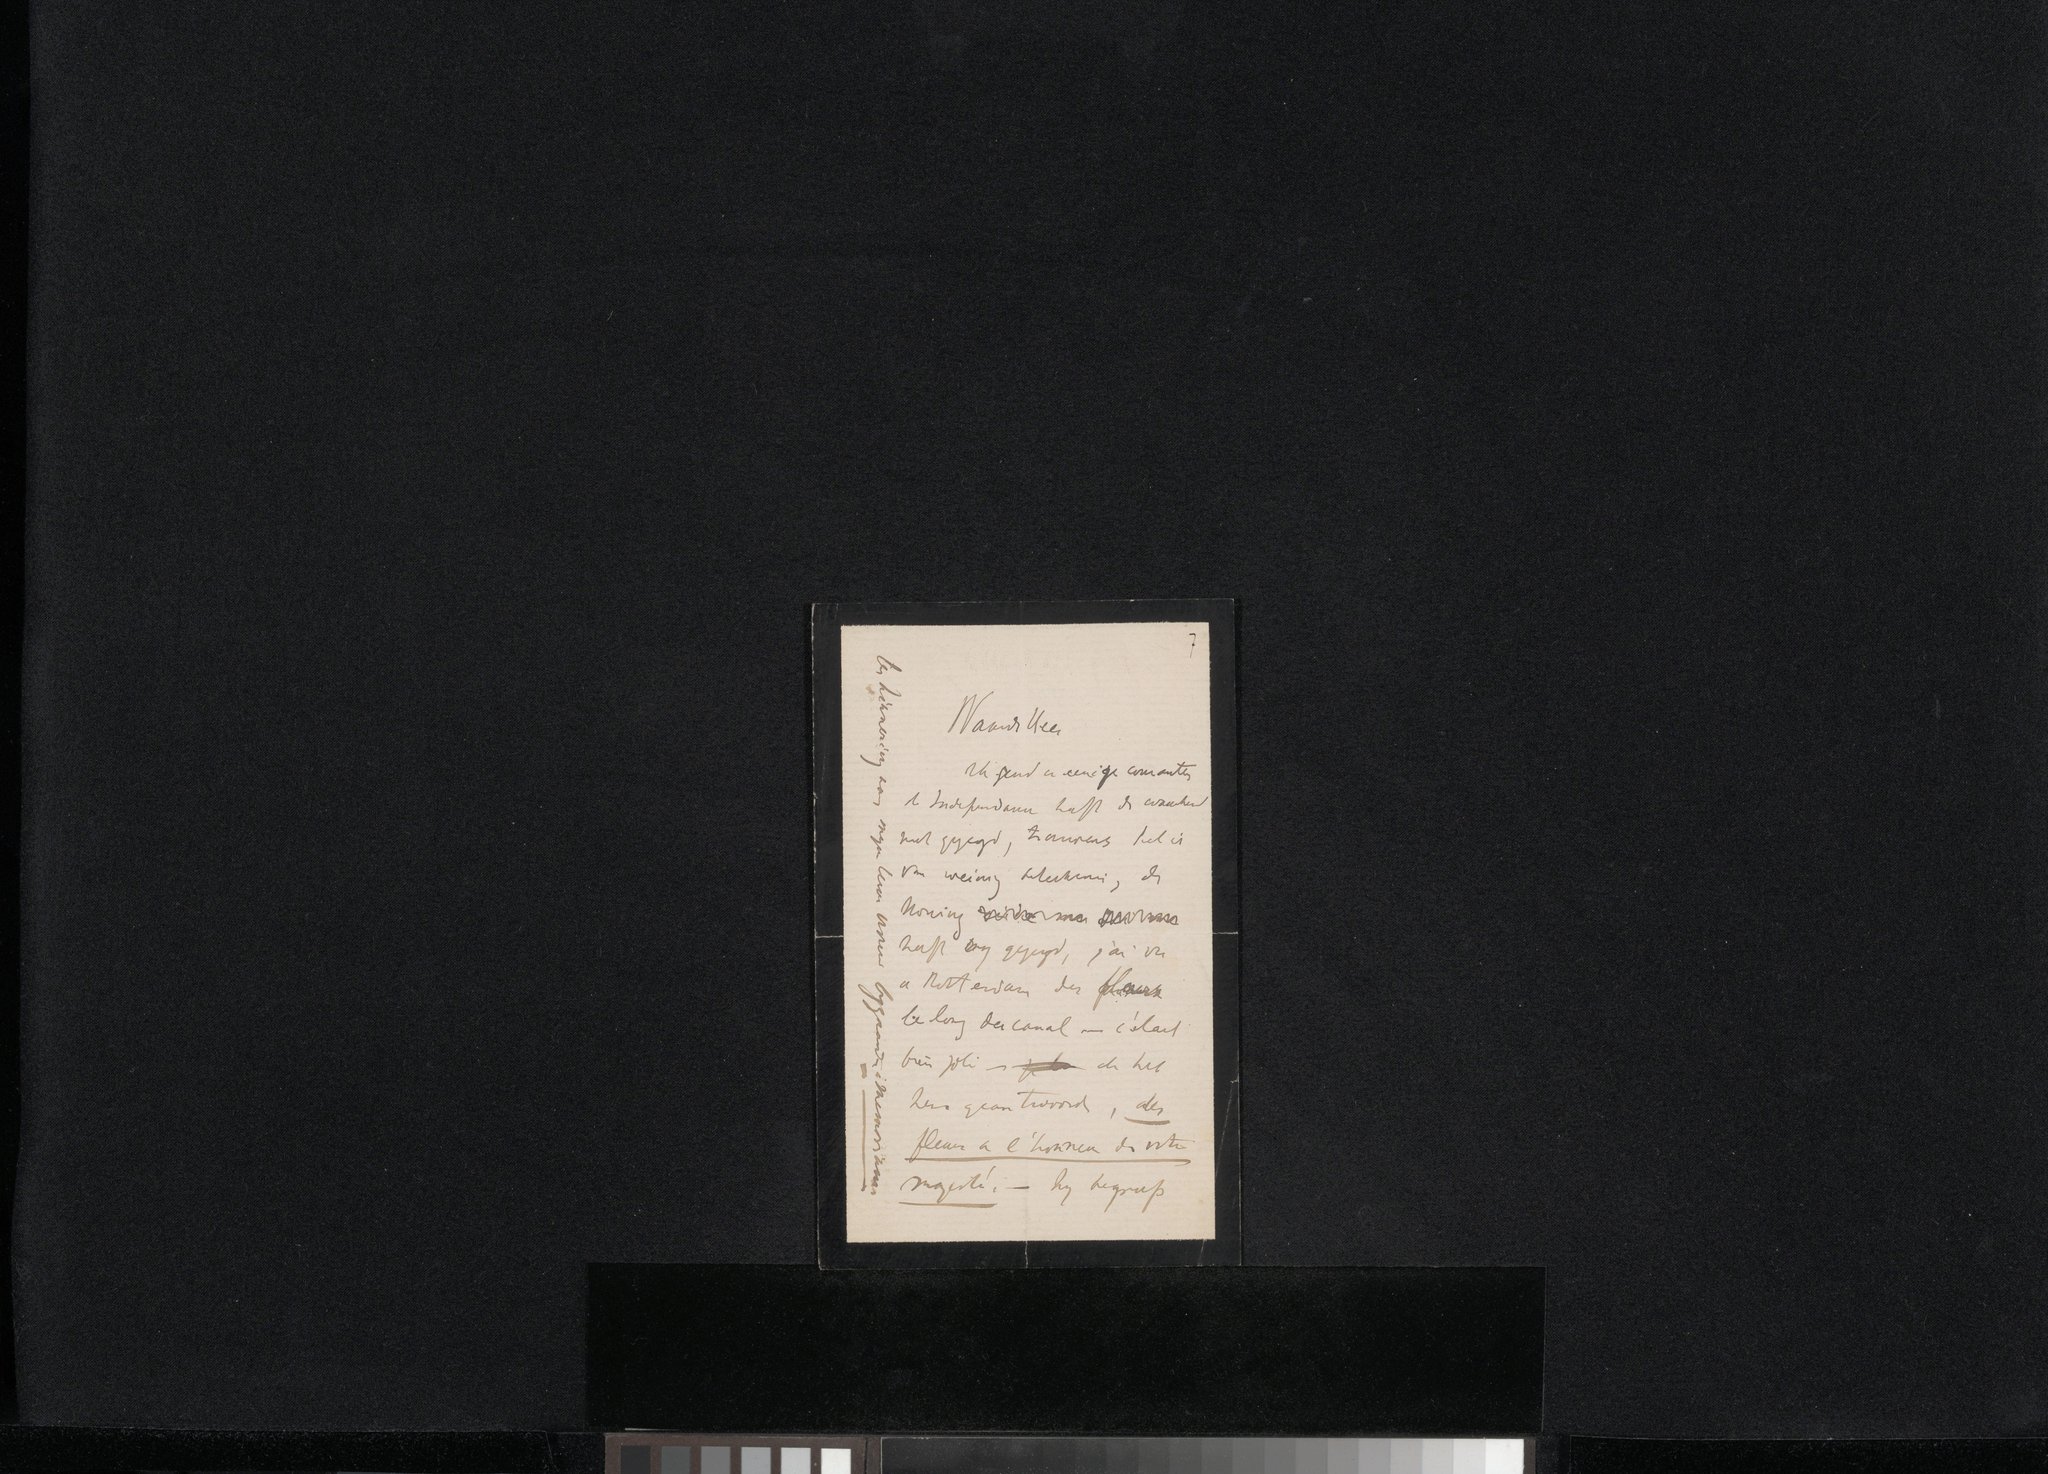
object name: letter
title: Brief aan anoniem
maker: jakob smits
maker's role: draughtsman, print maker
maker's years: 1855-1928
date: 1865-1928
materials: ink, paper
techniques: pen, writing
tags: rotterdam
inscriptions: collector's mark: ‘RPK’